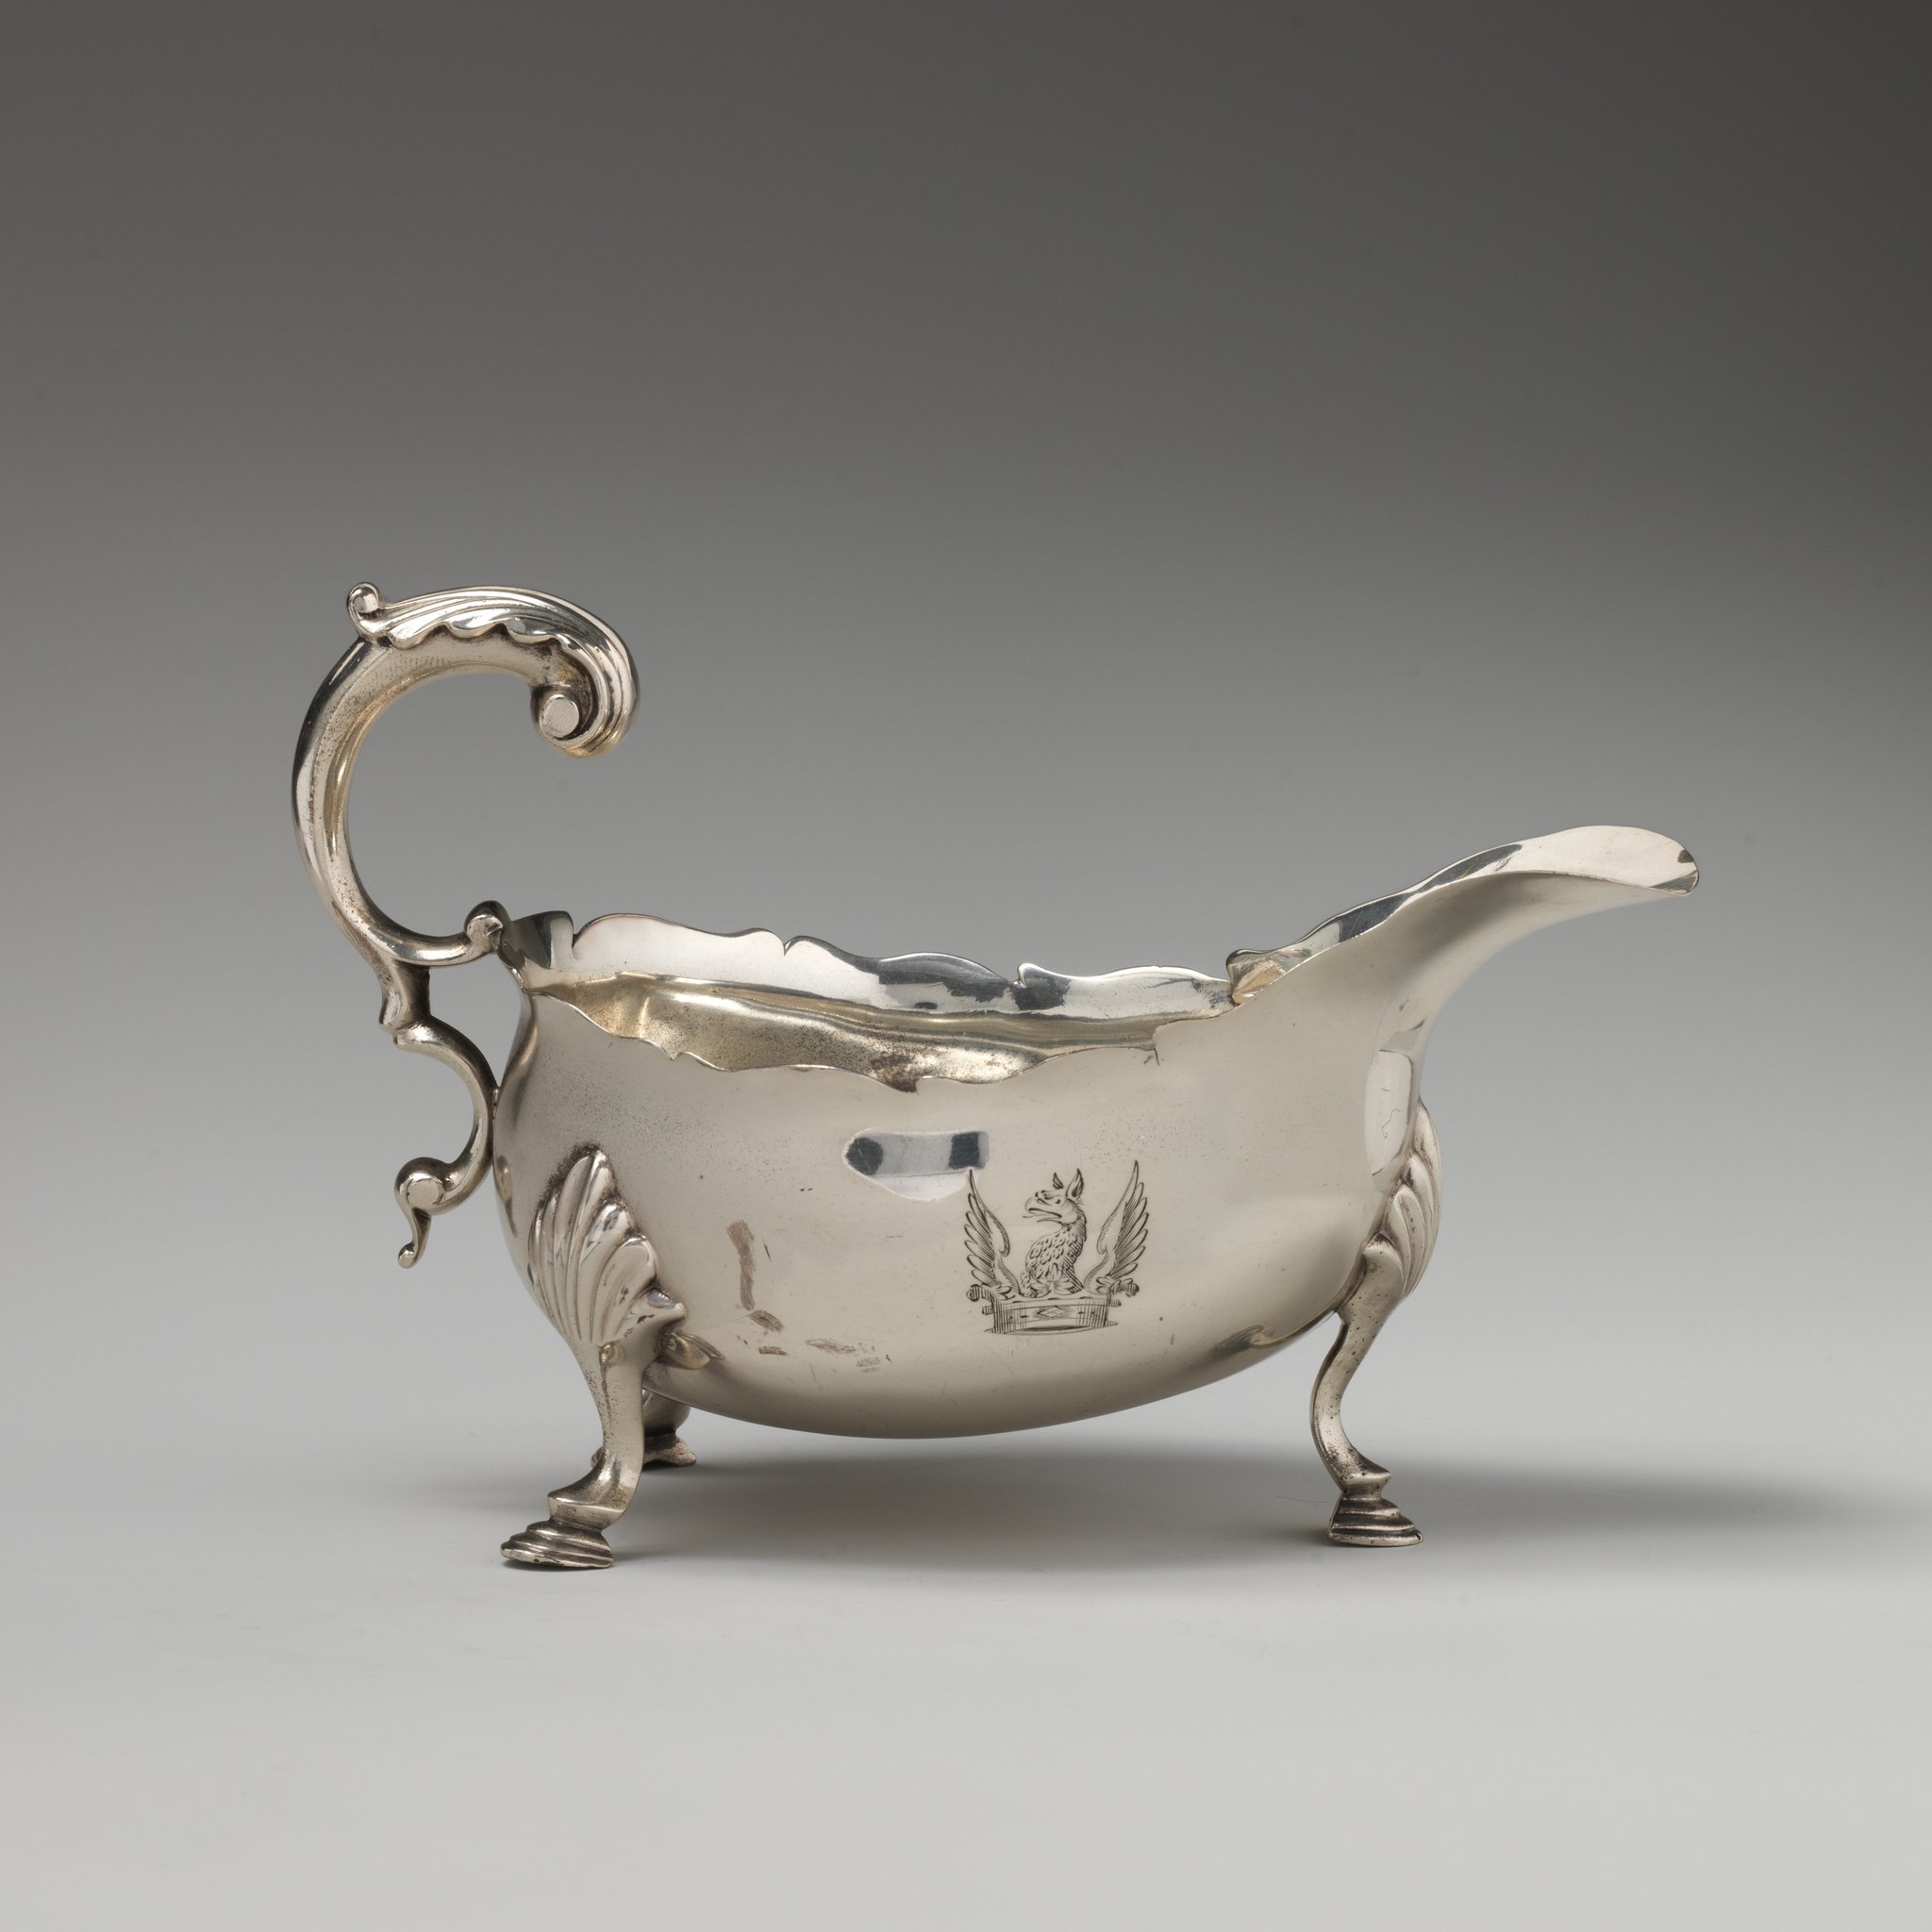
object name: sauceboat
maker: robert peaston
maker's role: maker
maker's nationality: british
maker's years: 1756-1766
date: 1765-1766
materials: silver